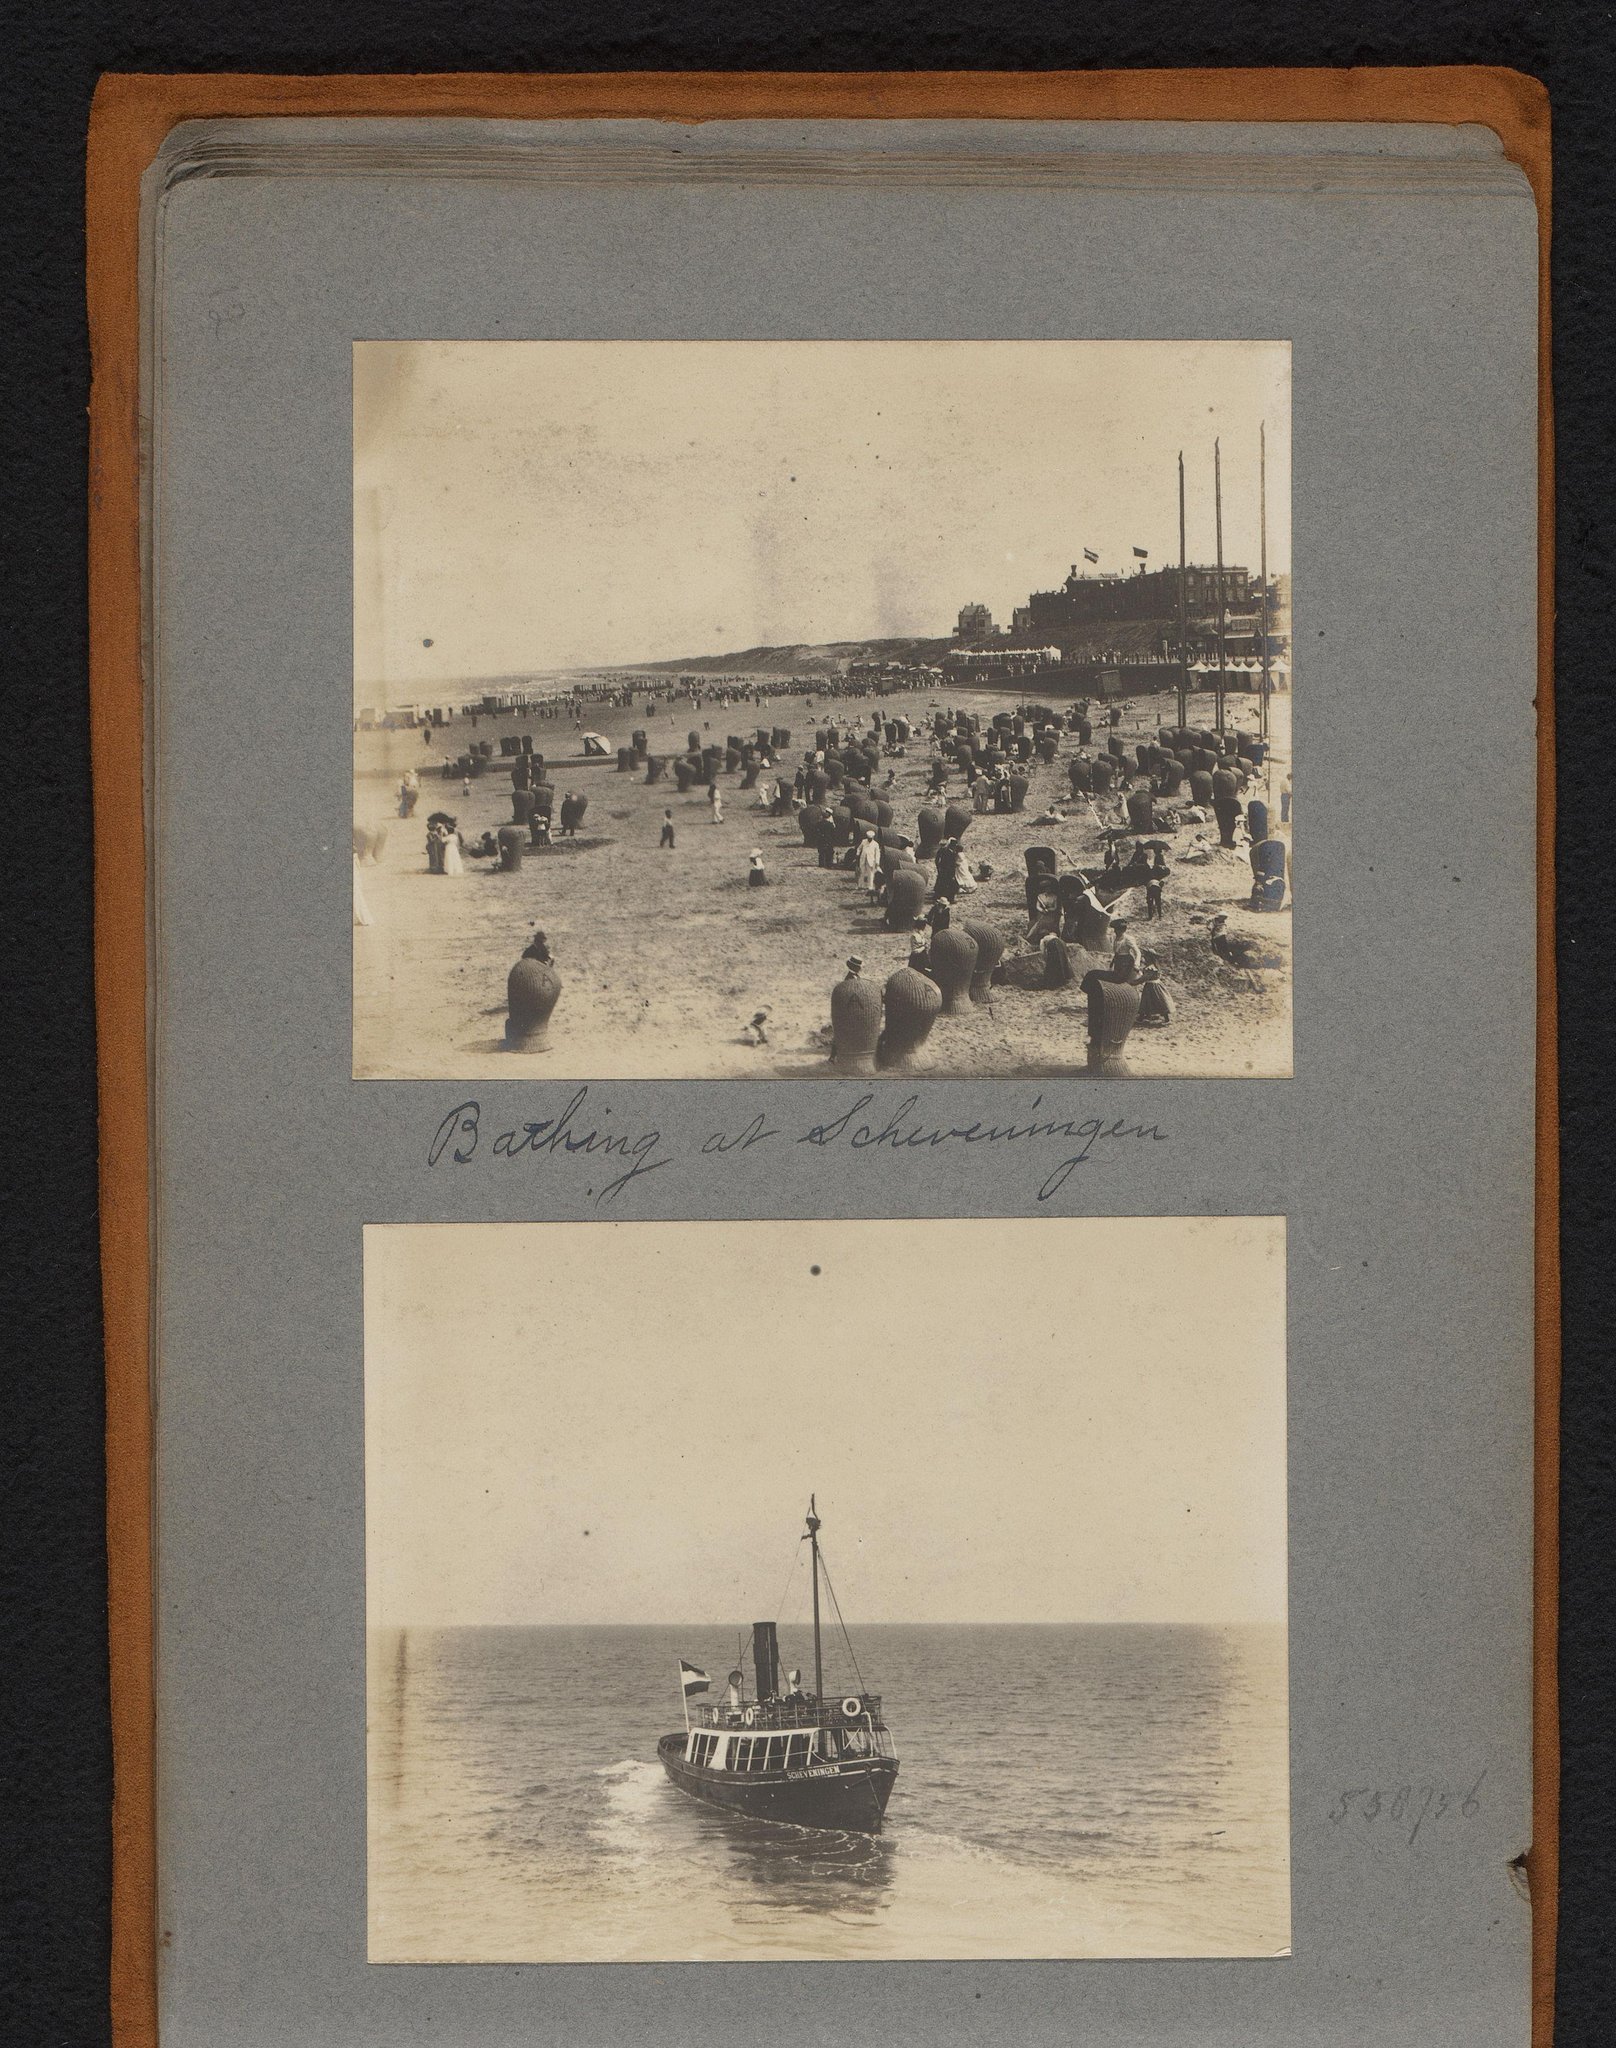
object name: photograph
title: Baden in Scheveningen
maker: jan van der mey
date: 1902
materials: paper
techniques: gelatin silver print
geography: scheveningen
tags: beach, steamship, motorship, in or beside the water (on the beach), historical persons not known by name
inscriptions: inscription: ‘Bathing at Scheveningen’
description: Deze foto's maken deel uit van een album.